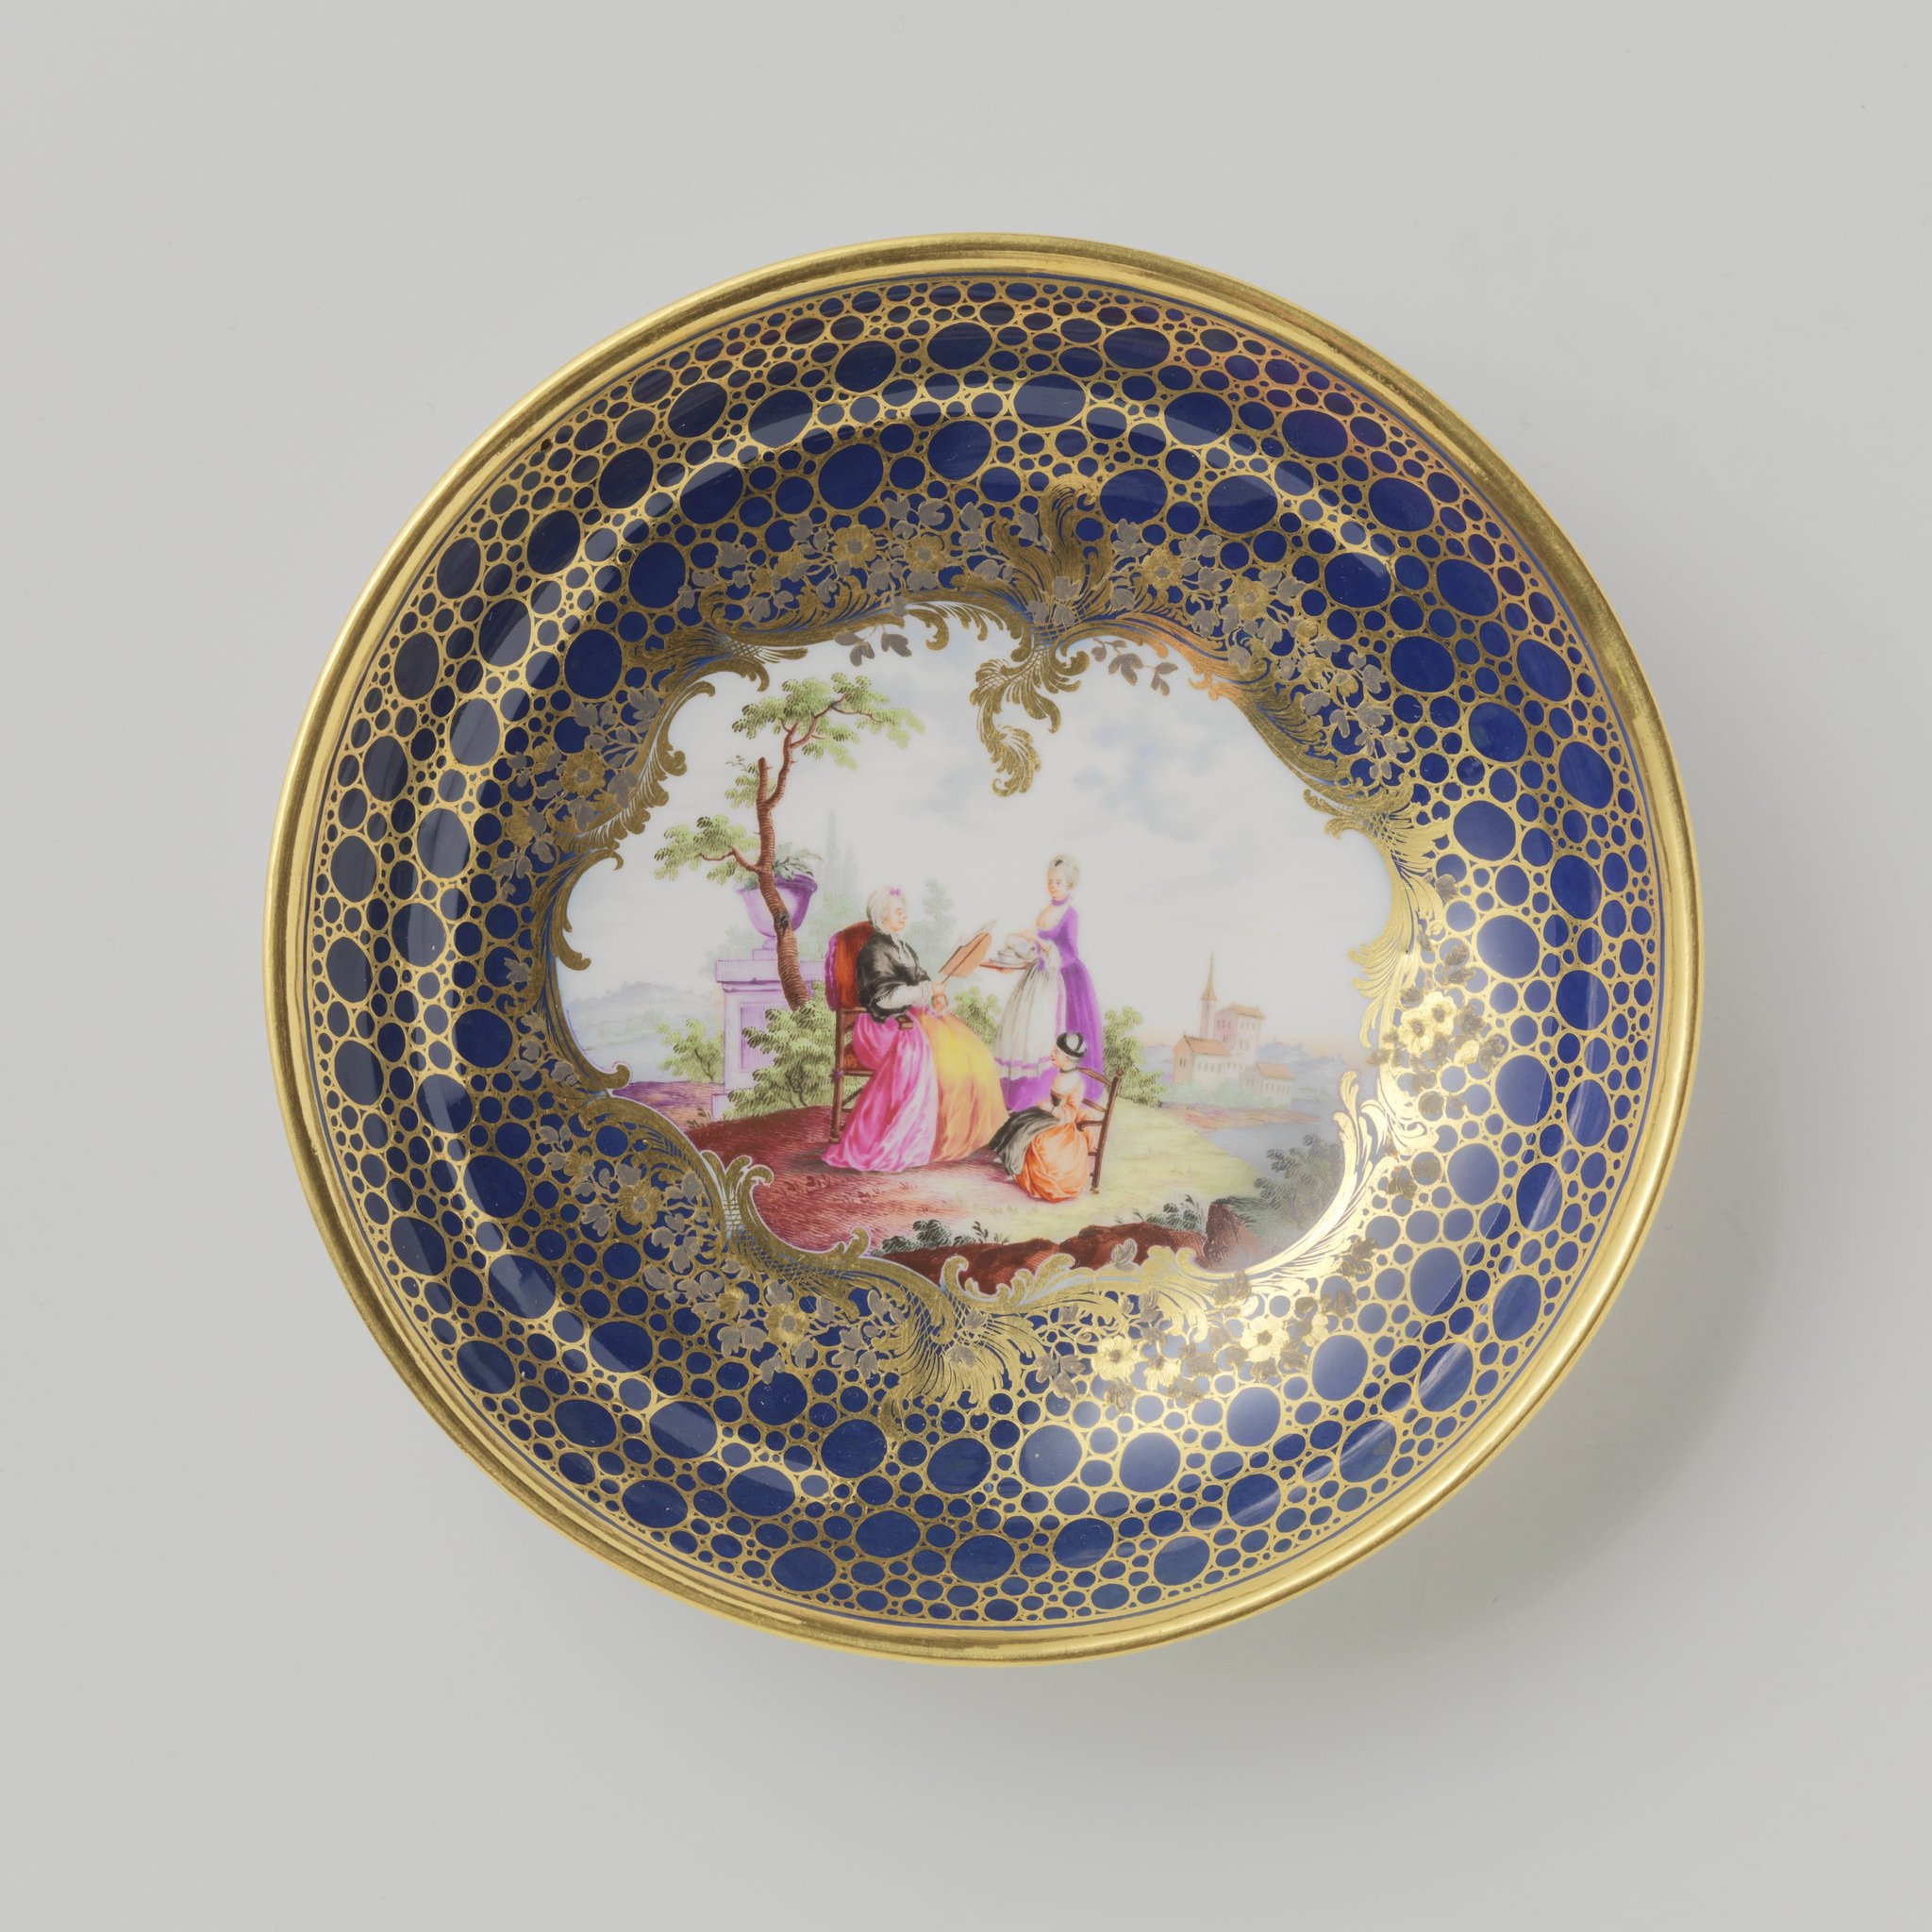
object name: platter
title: Saucer with a couple in a landscape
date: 1765-1770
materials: glaze, gold, paint, porcelain, silver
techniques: firing, gilding, turning, vitrification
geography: vienna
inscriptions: mark: ‘schild/ 29’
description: Schotel van porselein, beschilderd op het glauur in emailkleuren, zilver[?] en goud. De is bedekt met blauw waarover in goud een patroon van cirkels is aangebracht. Hierin uitgespaard op het plat een rocaille cartouche met daarin een dame met een meisje in een landschap, een bediende serveert een drank. De buitenrand met bloemranken. Gemerkt op de onderzijde met het schild en het nummer 29.